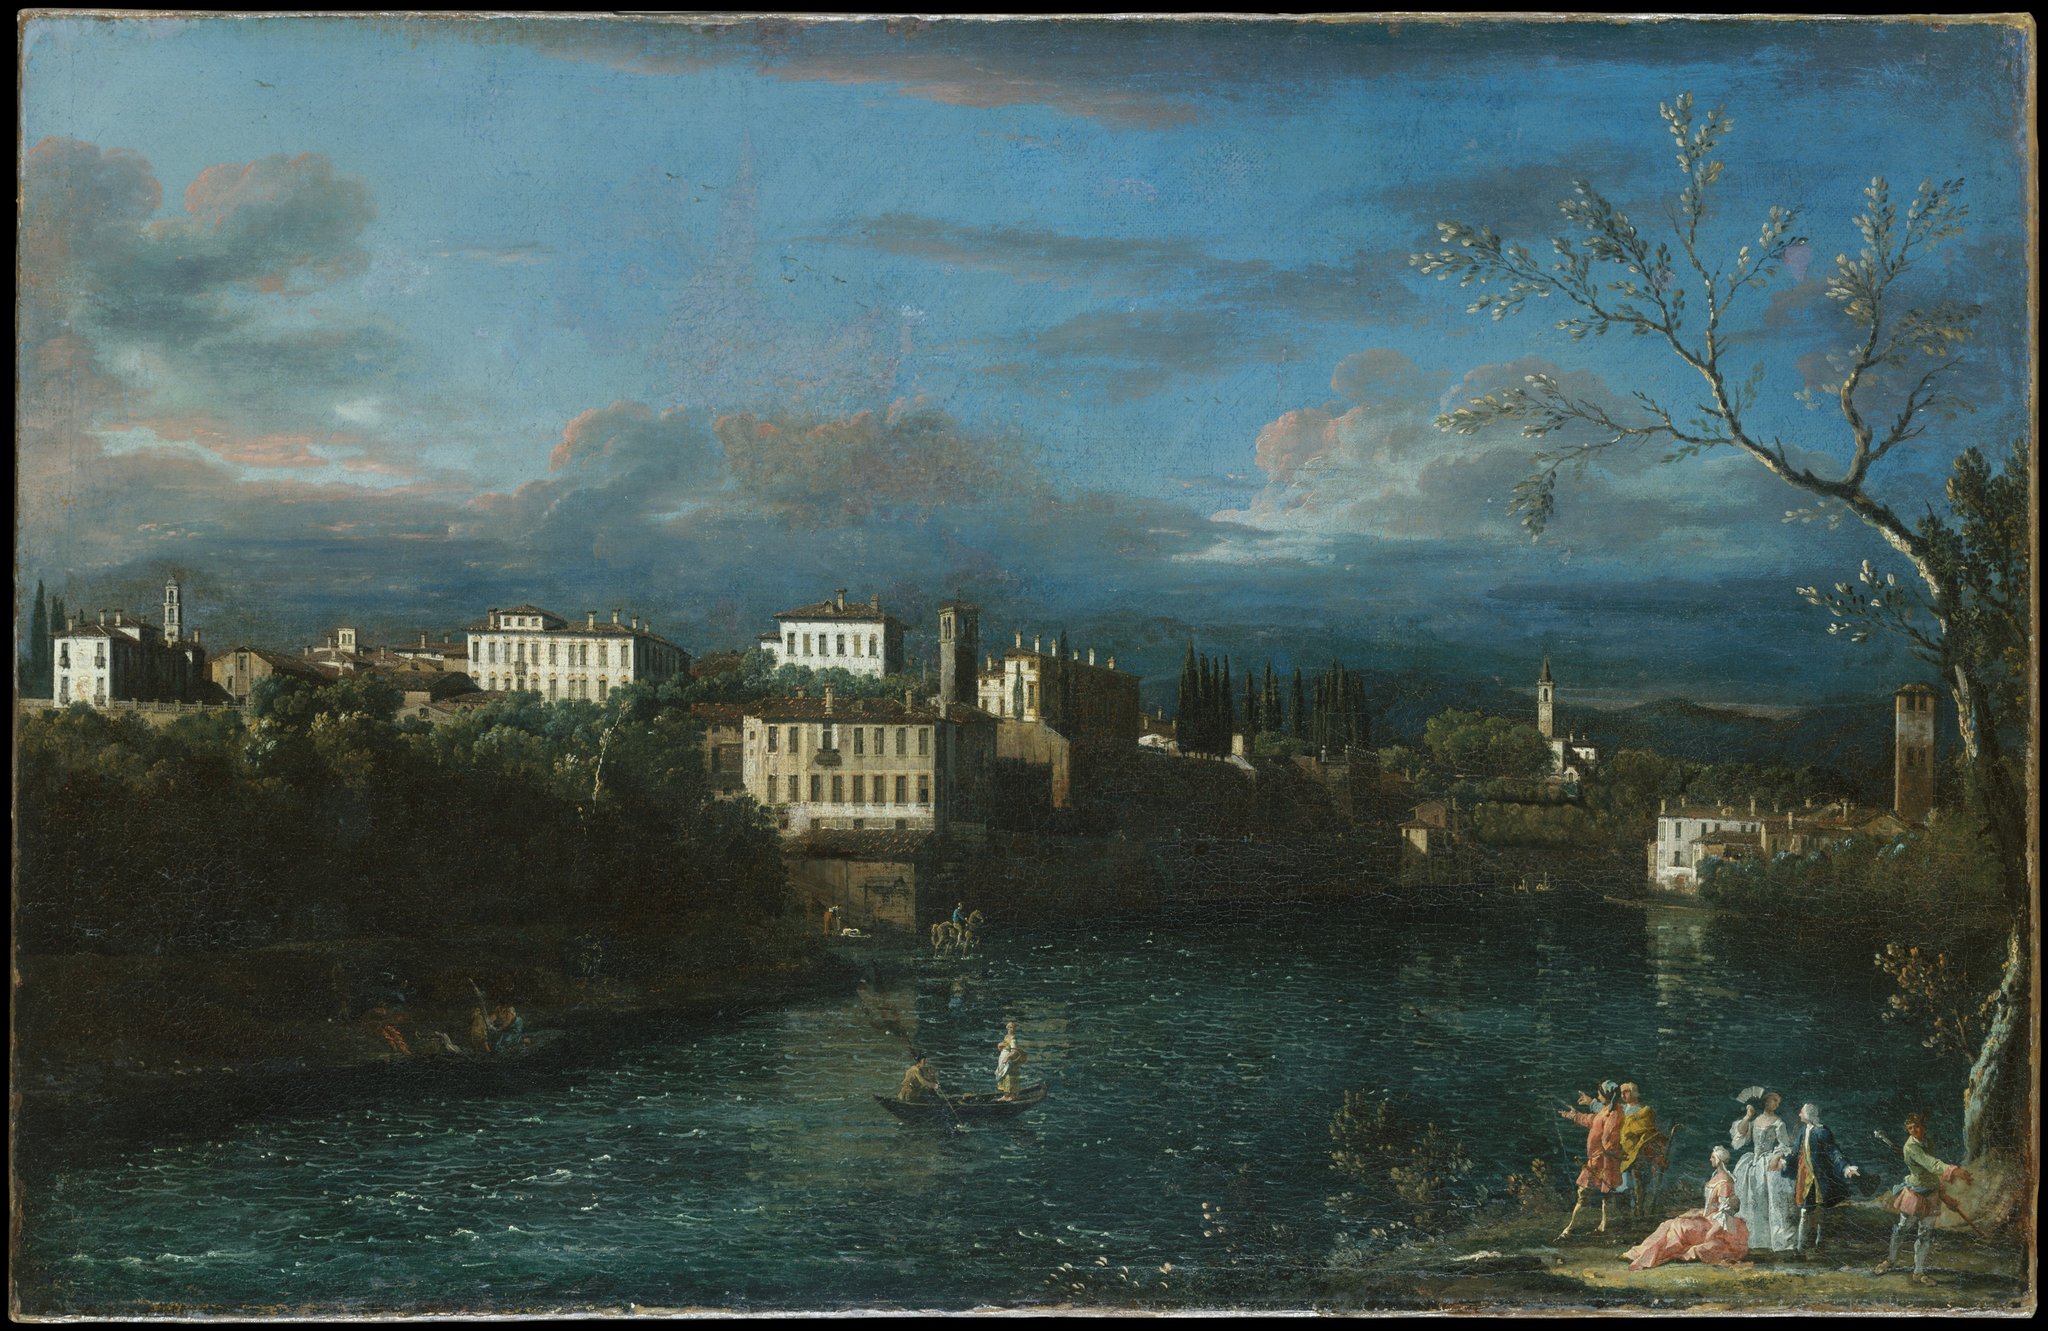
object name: painting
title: Vaprio d'Adda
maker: bernardo bellotto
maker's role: artist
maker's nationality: italian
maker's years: 1722-1780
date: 1744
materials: canvas, oil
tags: towns,rivers,boats